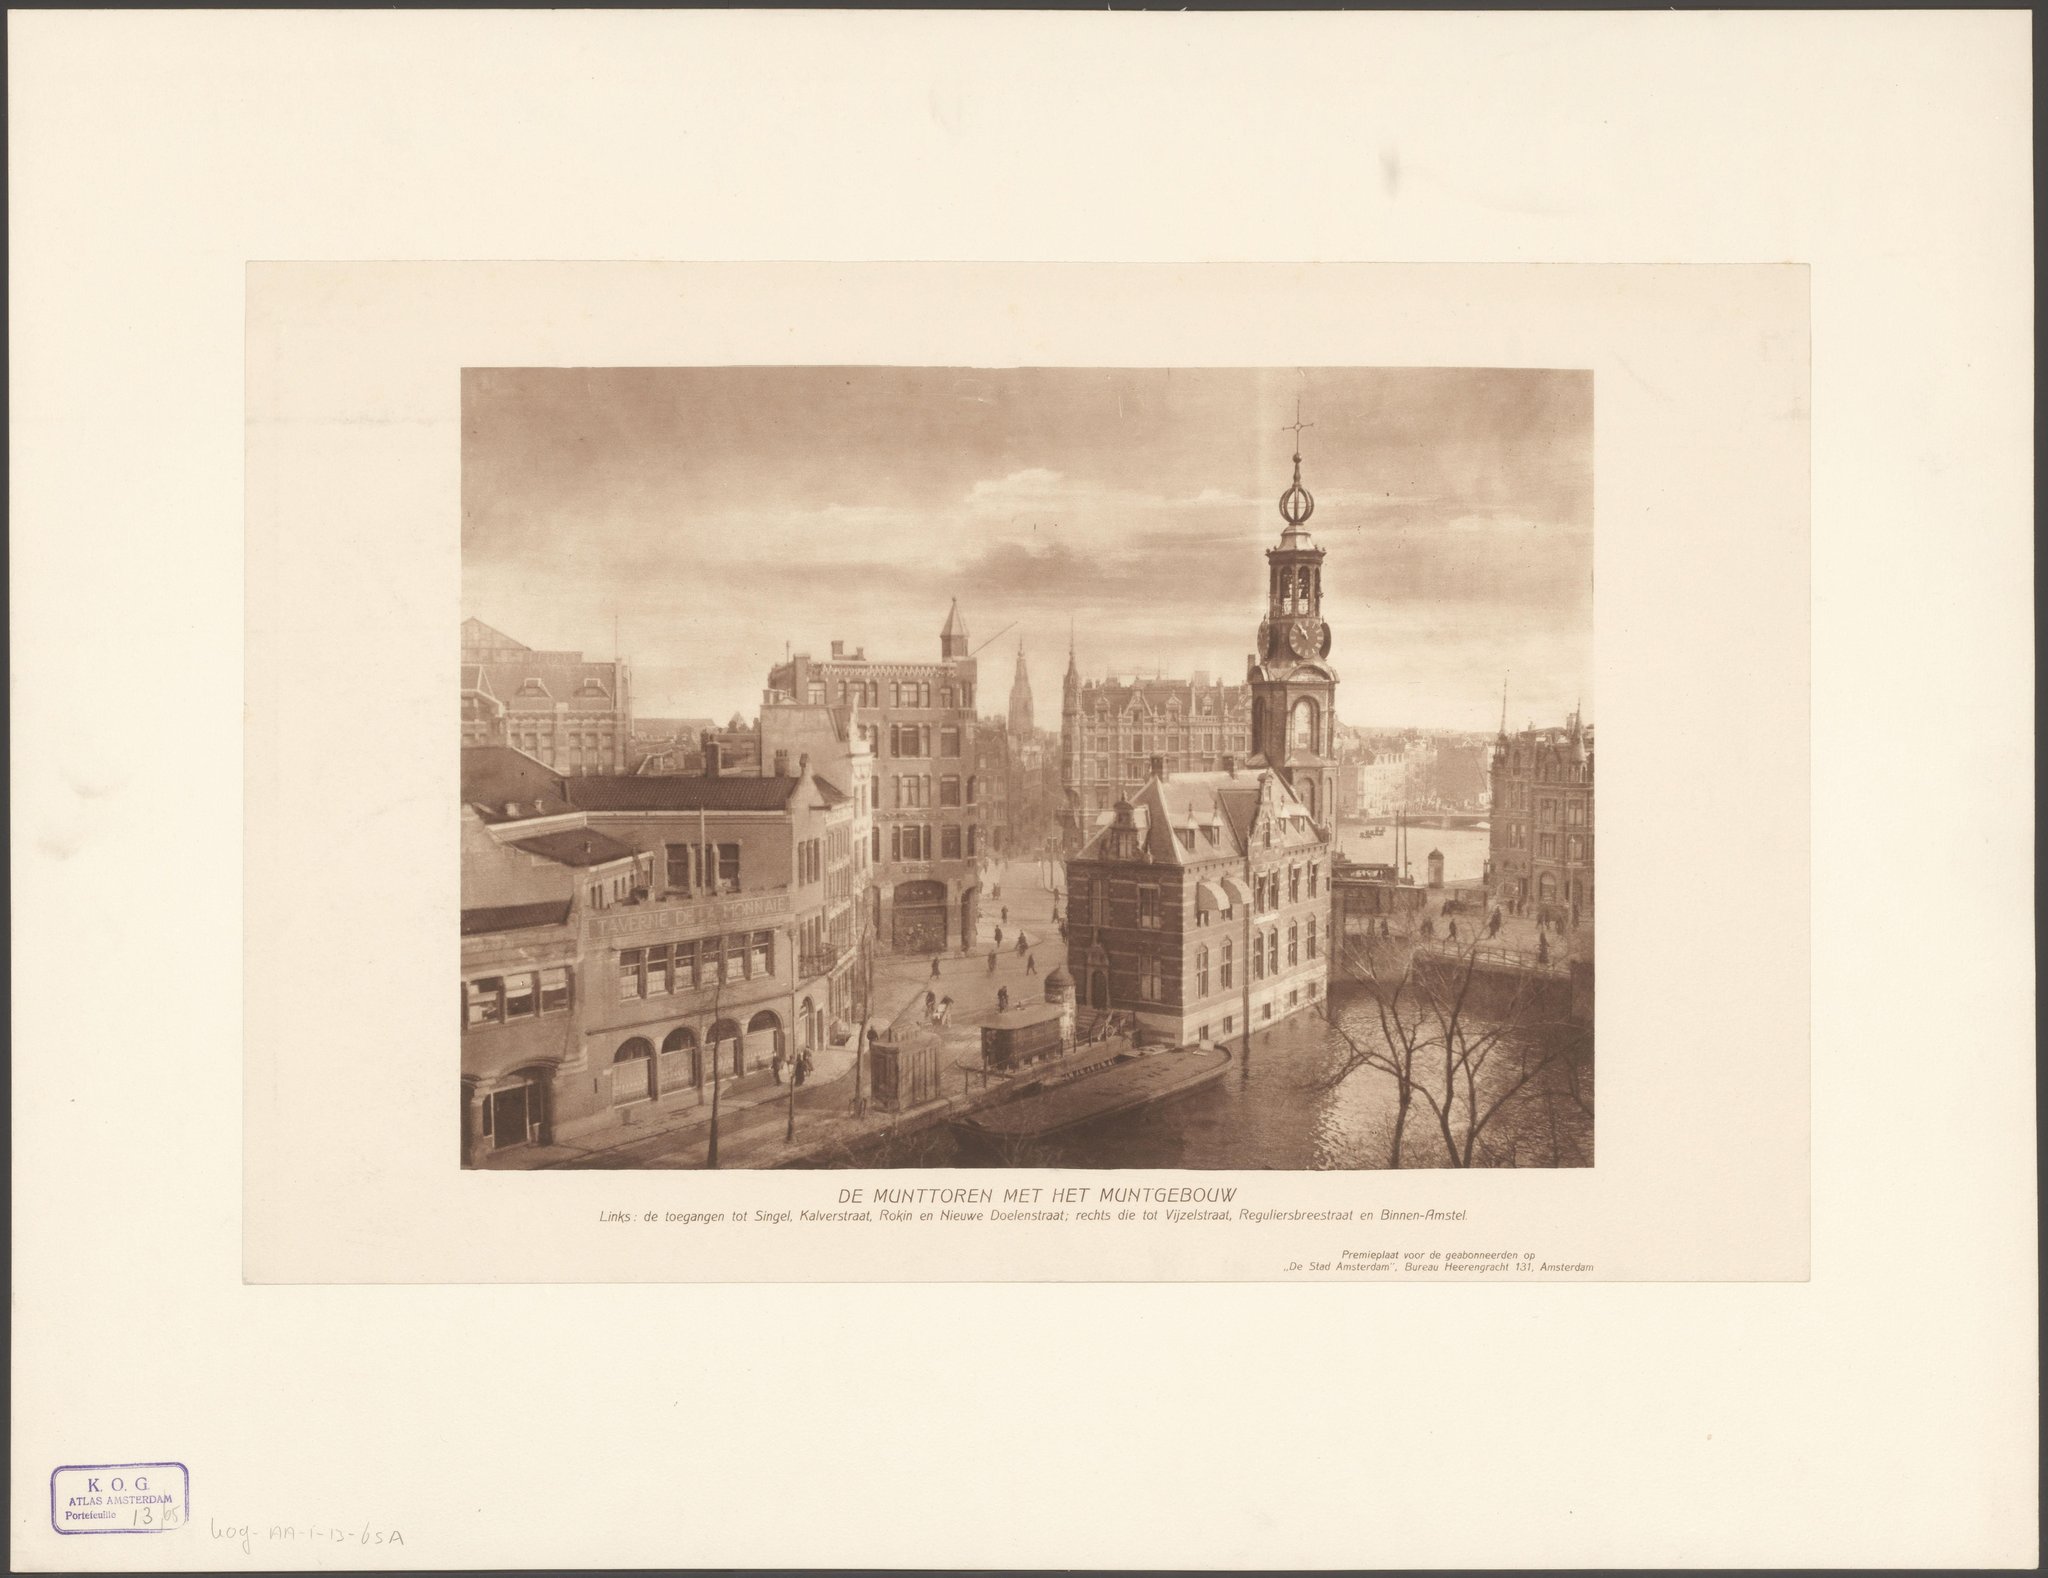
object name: photomechanical print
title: Gezicht op de Munttoren vanaf het Singel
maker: Anonymous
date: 1875-1930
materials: cardboard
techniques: photograph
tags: tower, clock tower ~ monumental adornment, city-view in general; 'veduta', canal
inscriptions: collector's mark: ‘13,65’ Lugt 1641b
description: Onderwerpsrubriek binnen de Atlas Amsterdam: Oude Schans, Schoutensteeg, Singel (Korte), Singel.